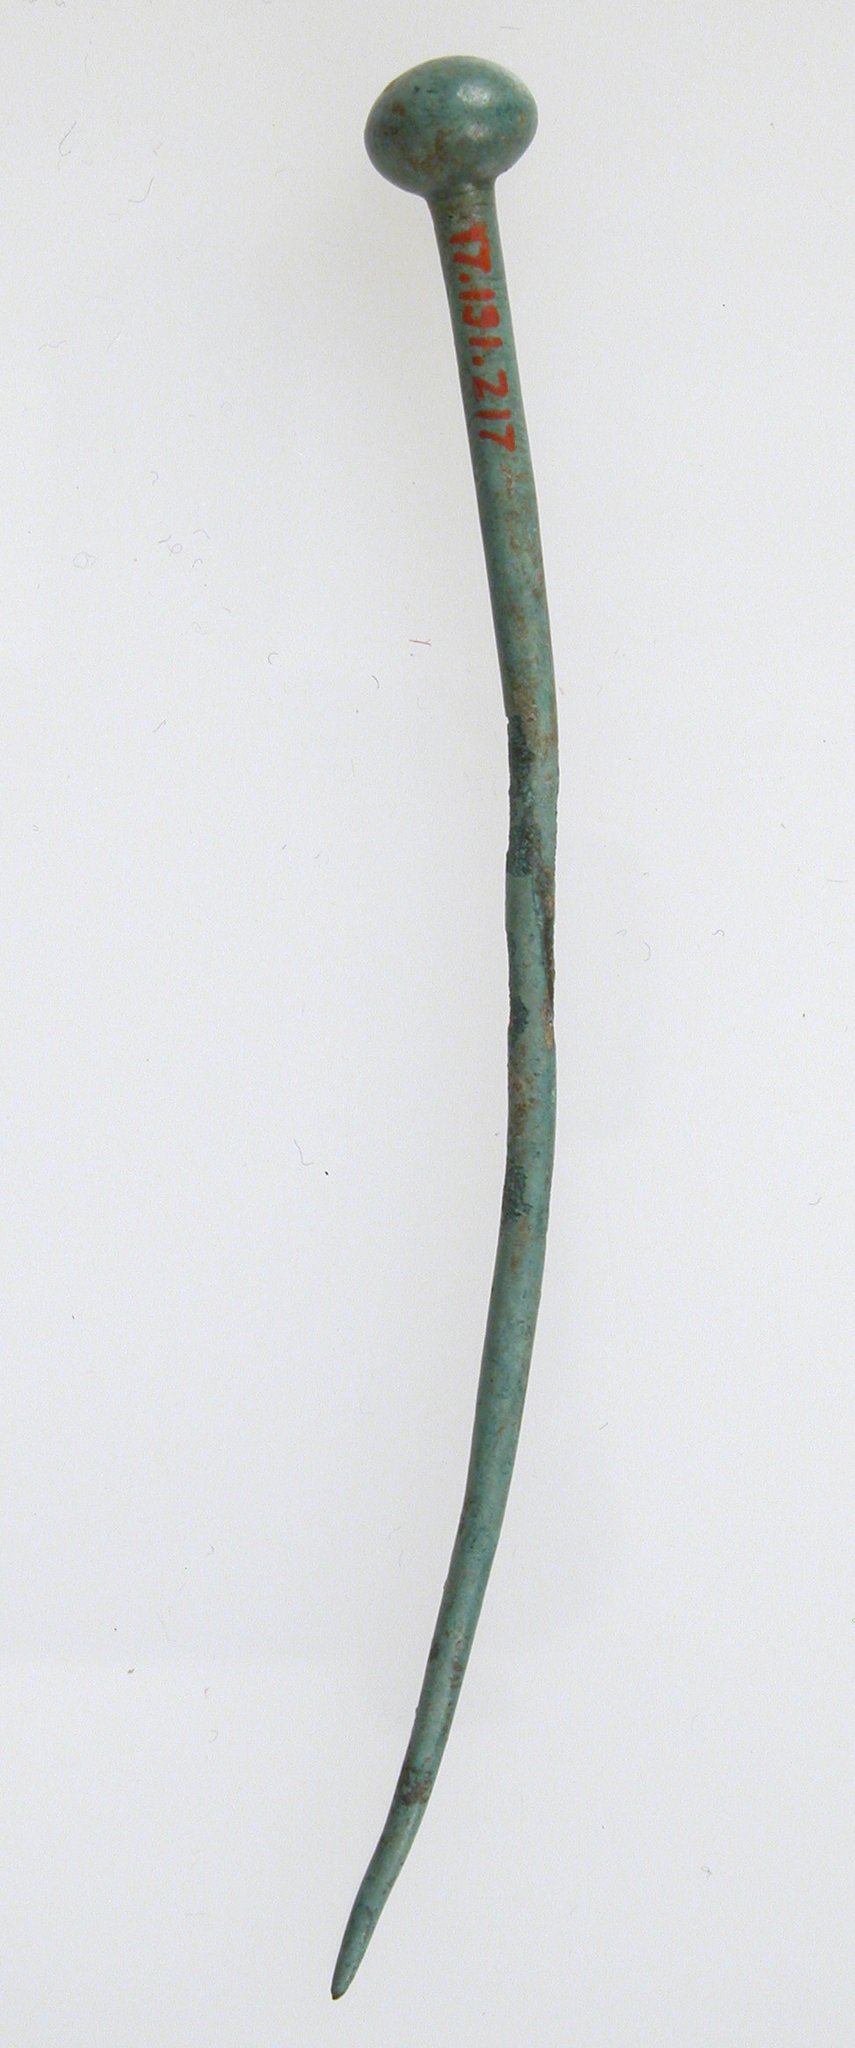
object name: hairpin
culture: roman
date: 200-500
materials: copper alloy